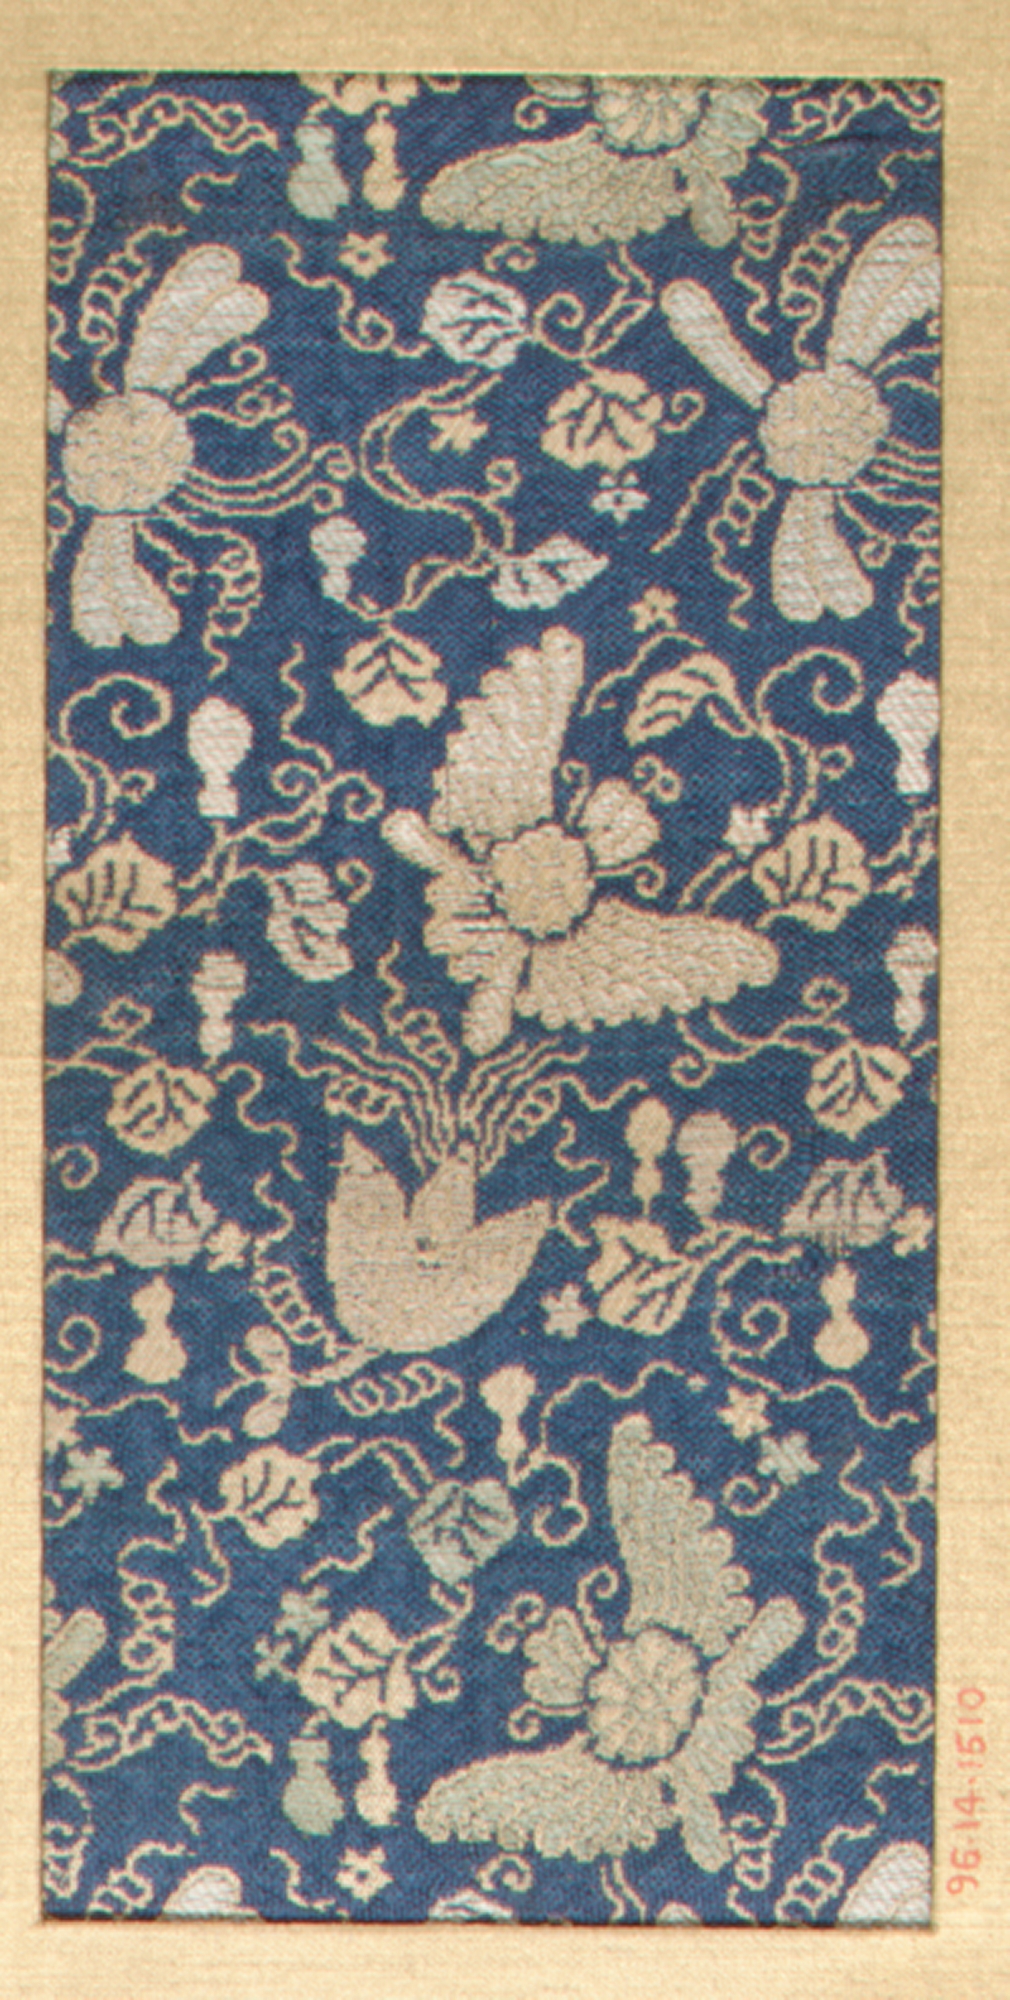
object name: piece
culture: japanese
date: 1701-1900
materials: silk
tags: butterflies,flowers